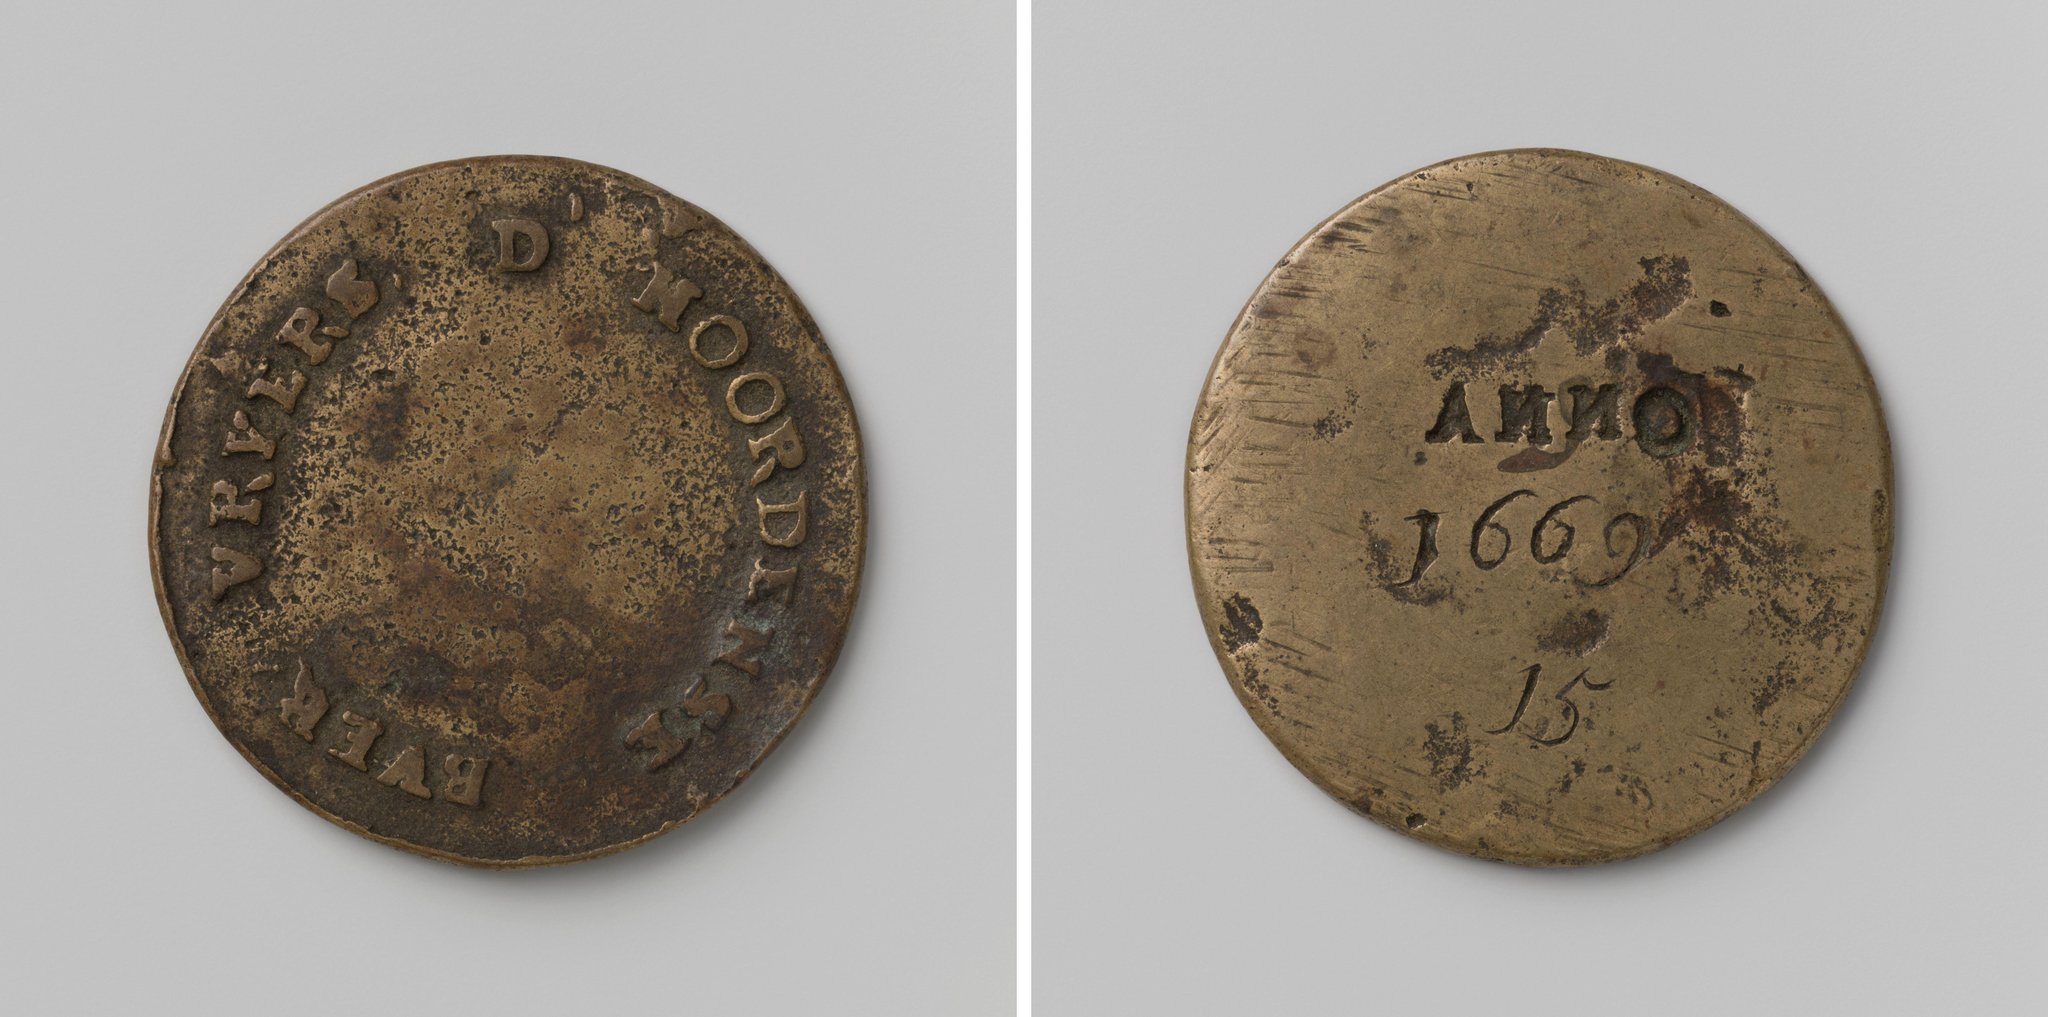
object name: buurtpenning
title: Buurt Noordeinde te 's-Gravenhage, penning van de buurtvrijers met no. 15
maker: Anonymous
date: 1669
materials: brass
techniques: casting, engraving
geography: the hague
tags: noordeinde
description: Messing penning. Voorzijde: leeg veld binnen omschrift. Keerzijde: jaartal boven cijfer 15